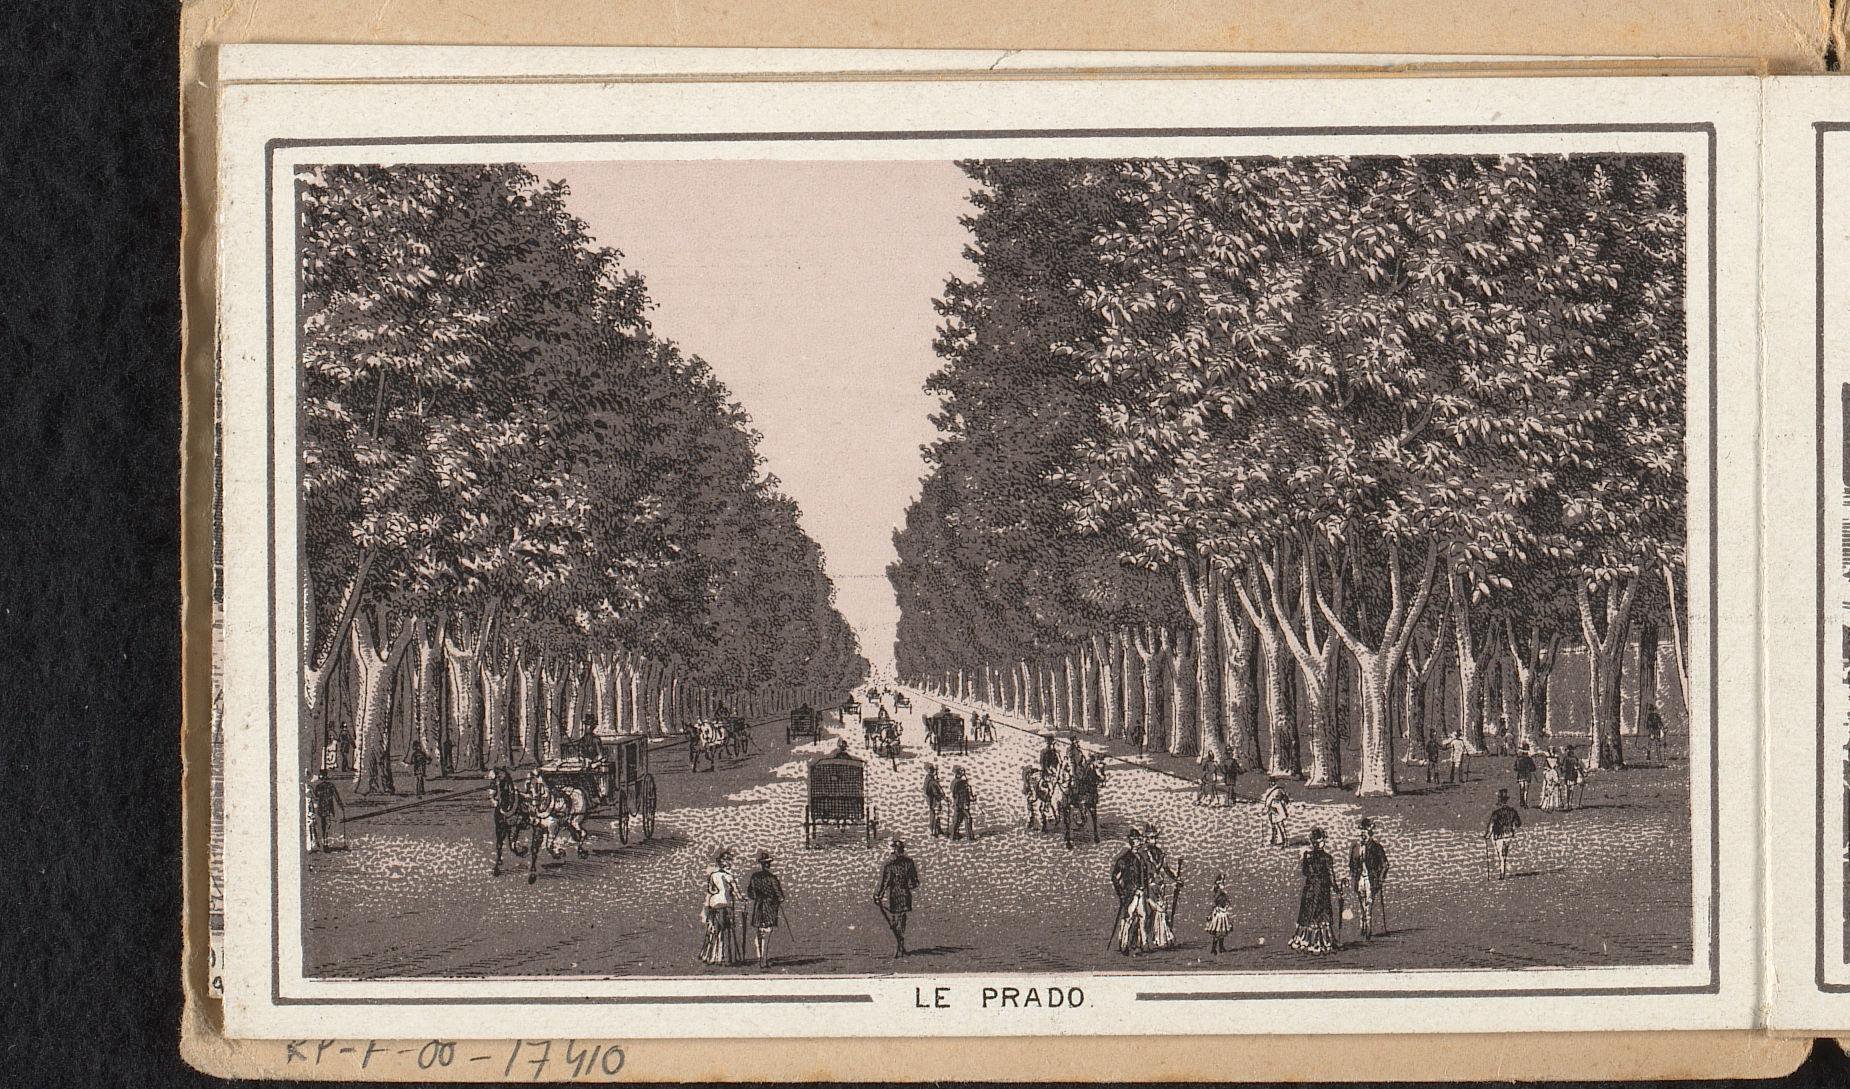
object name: print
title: Le Prado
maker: Anonymous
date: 1890-1910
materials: cardboard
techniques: lithograph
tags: trees, public gardens, park (+ city(-scape) with figures, staffage), marseille